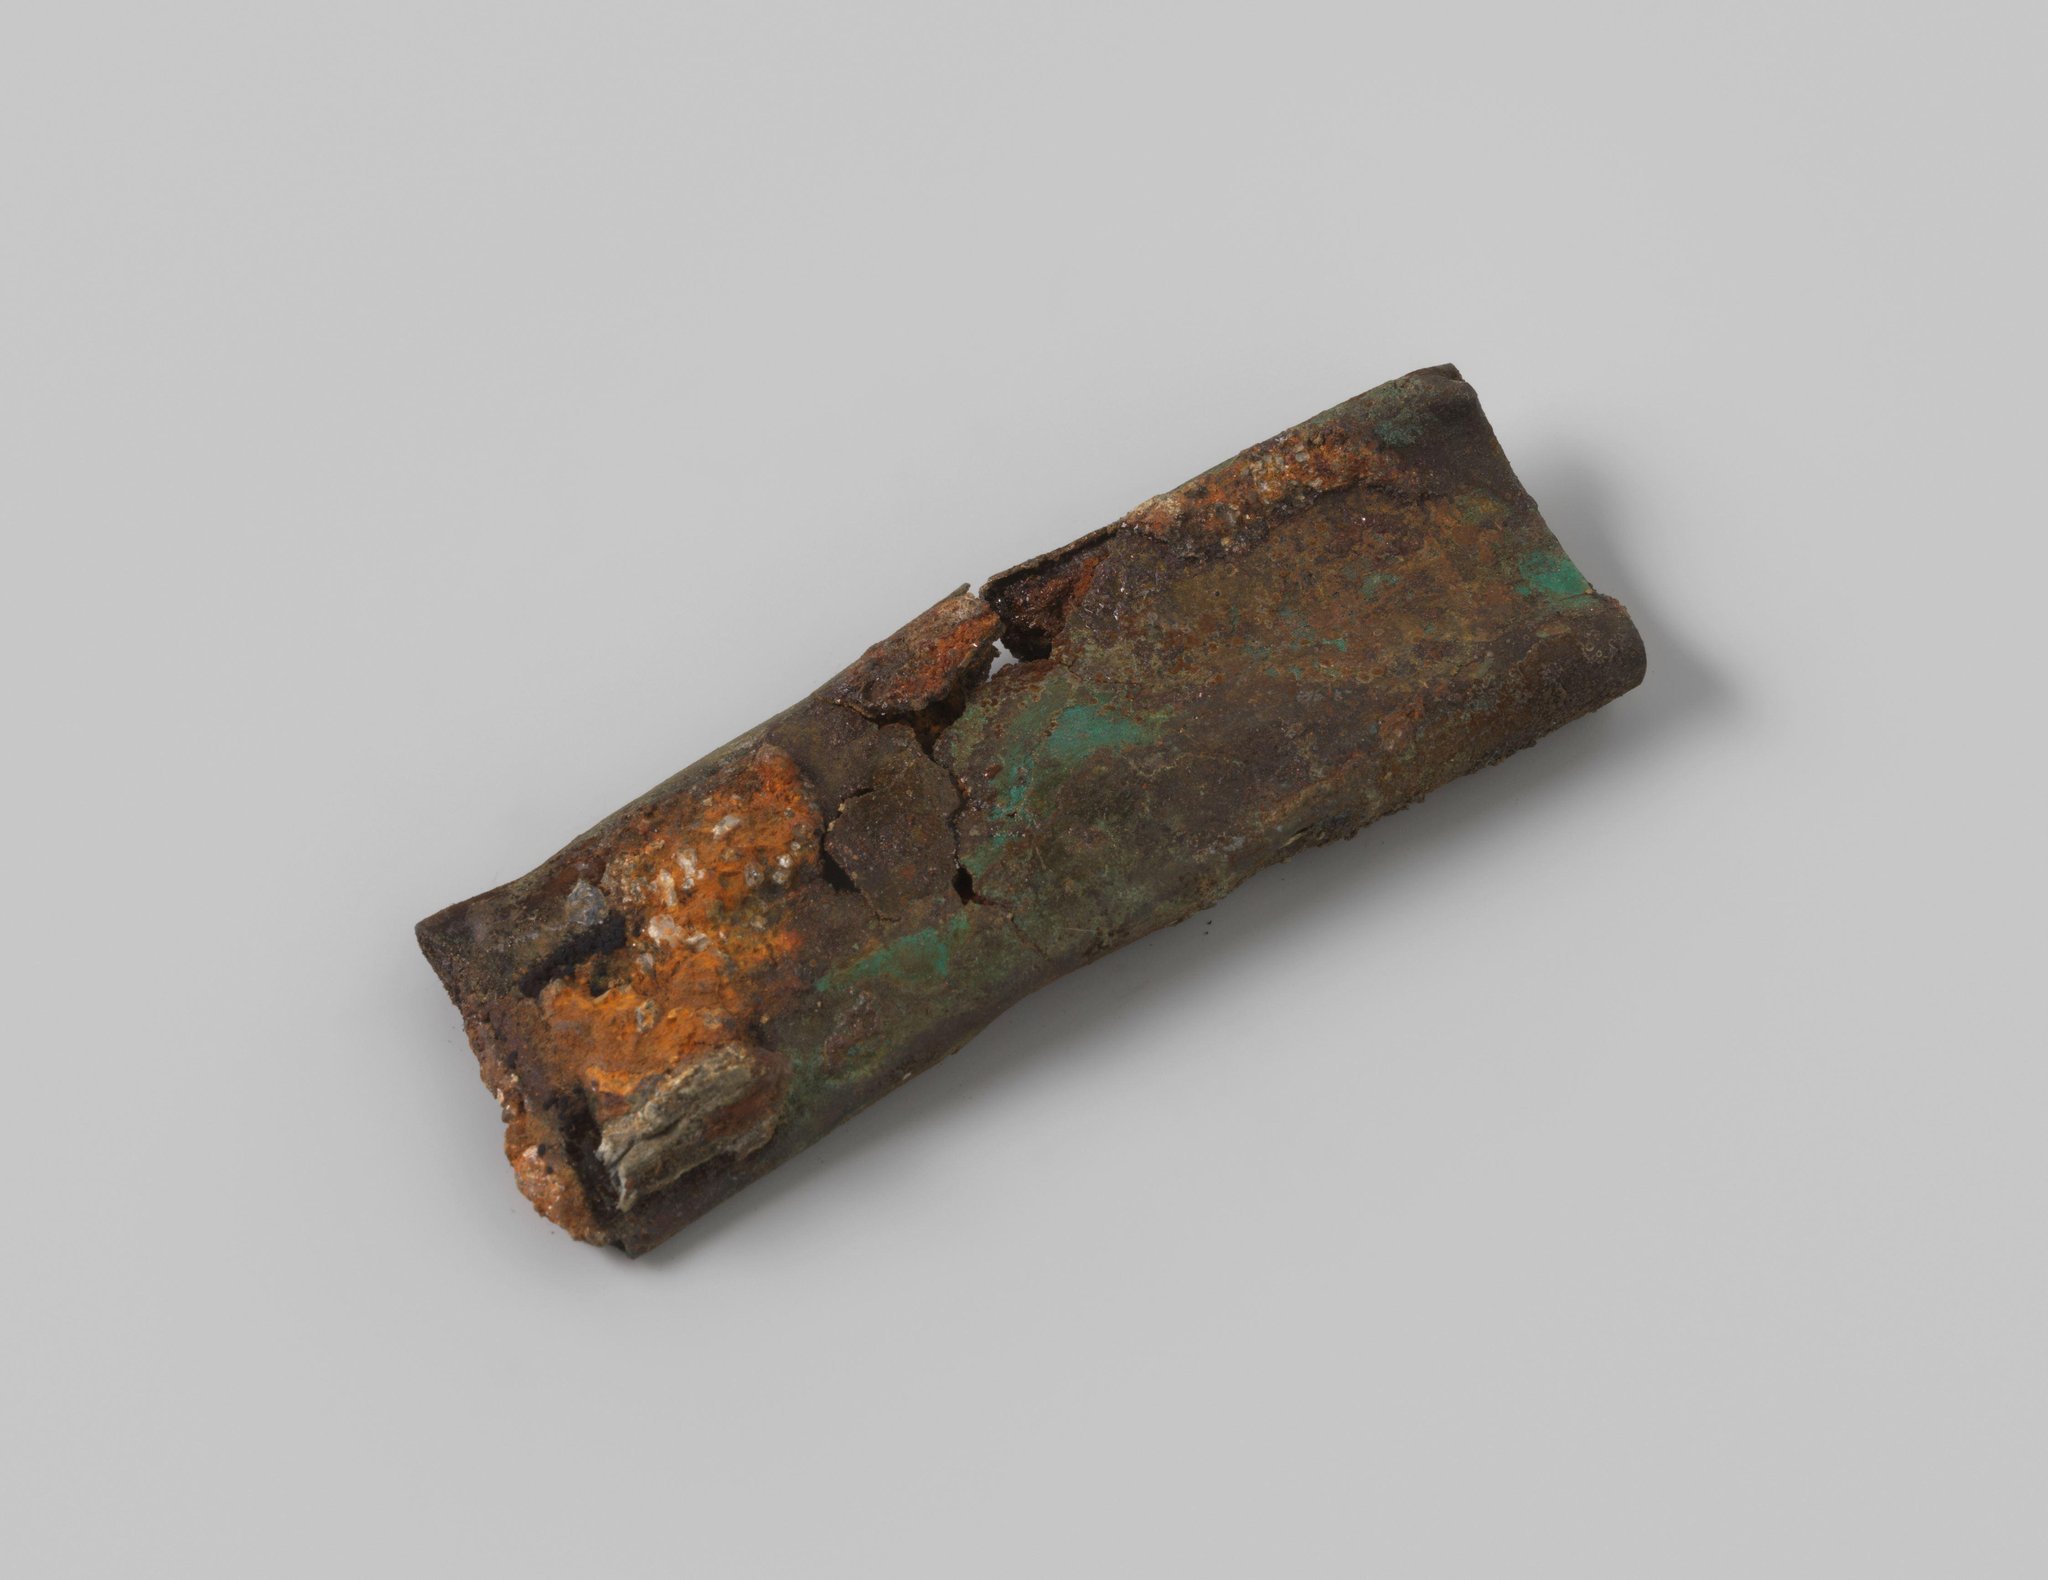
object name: cartridge shell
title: Patroonhuls uit het wrak van de Oost-Indiëvaarder Hollandia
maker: Anonymous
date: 1700-1743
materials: copper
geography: netherlands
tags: verenigde oostindische compagnie, hollandia (schip), annet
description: Cartridge case, tube; eroded, squashed, id. NG 1979-205H549.